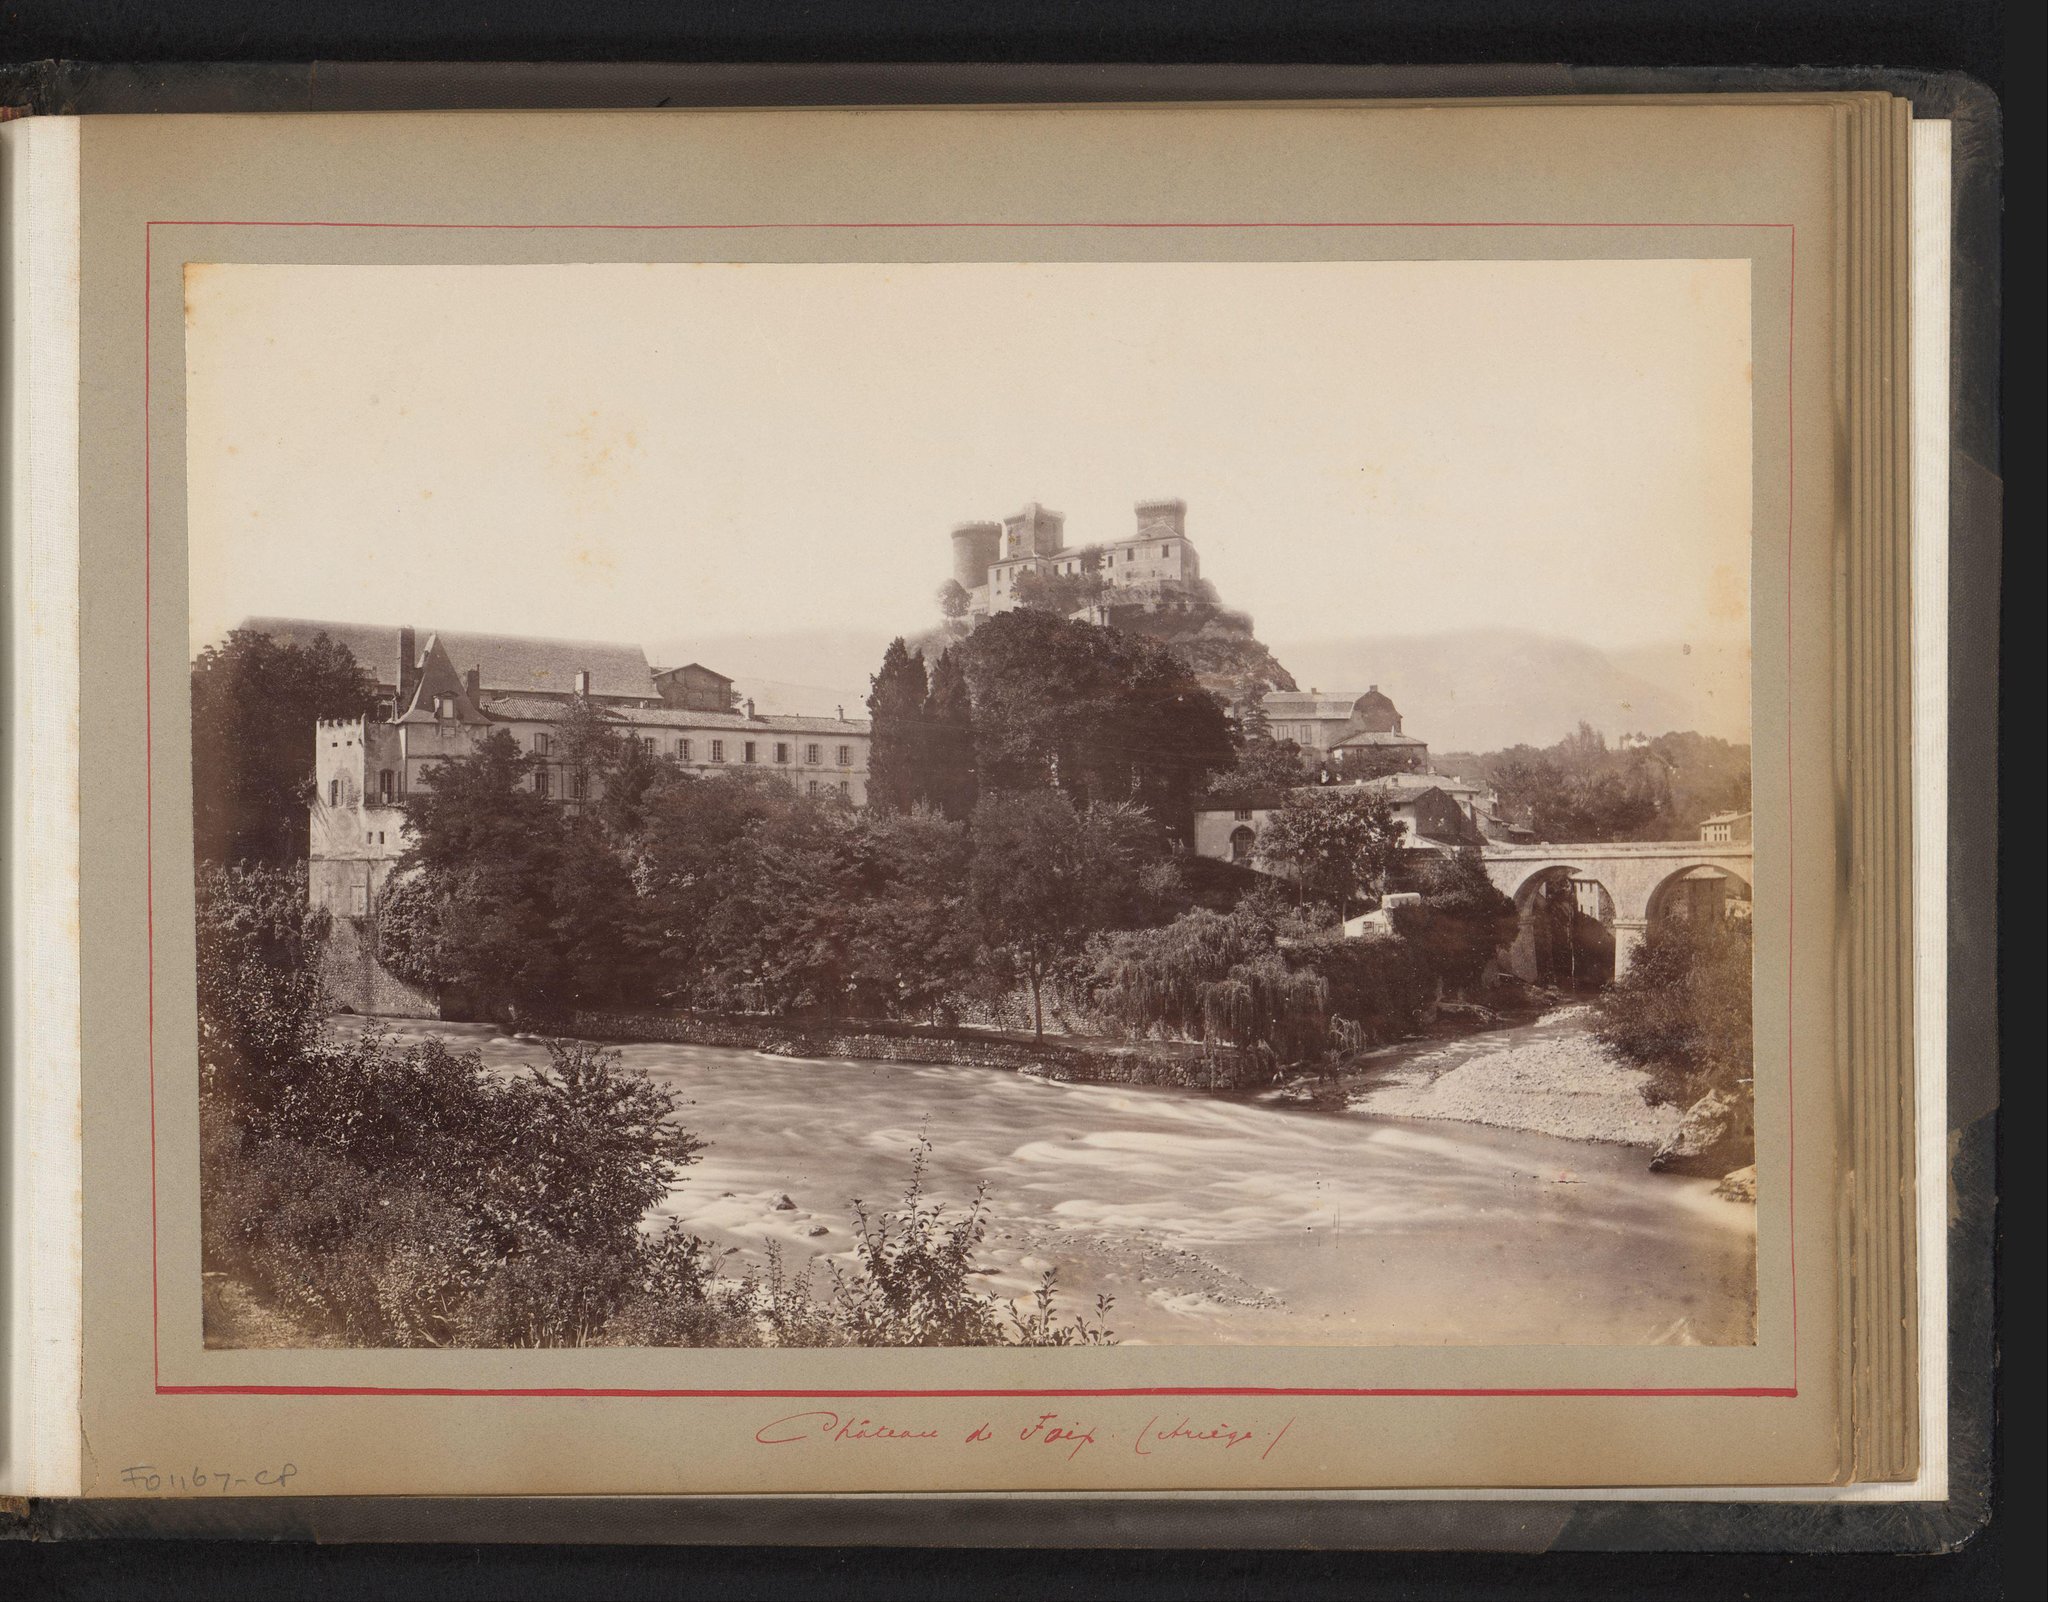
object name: photograph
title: Rivier bij het kasteel van Foix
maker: Anonymous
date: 1880-1910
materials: photographic support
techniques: albumen print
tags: castle, river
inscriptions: annotation: ‘Château de Foix (Ariège/’